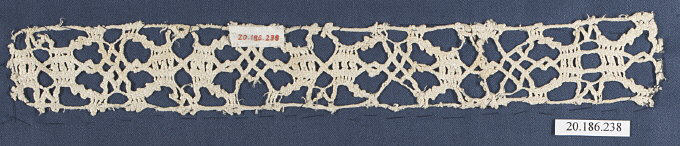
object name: insertion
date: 1501-1600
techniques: lace